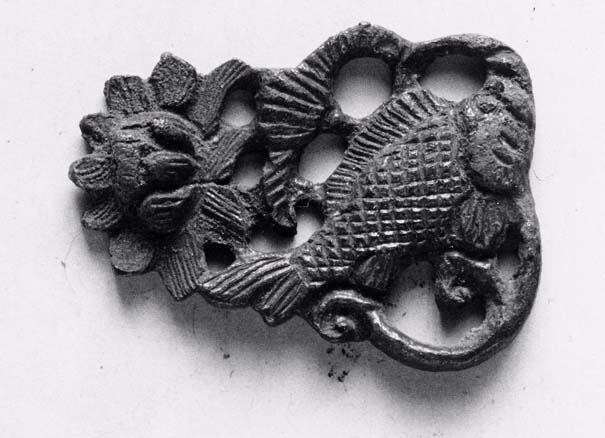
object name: ornament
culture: korean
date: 918-1392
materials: silver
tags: fish,flowers